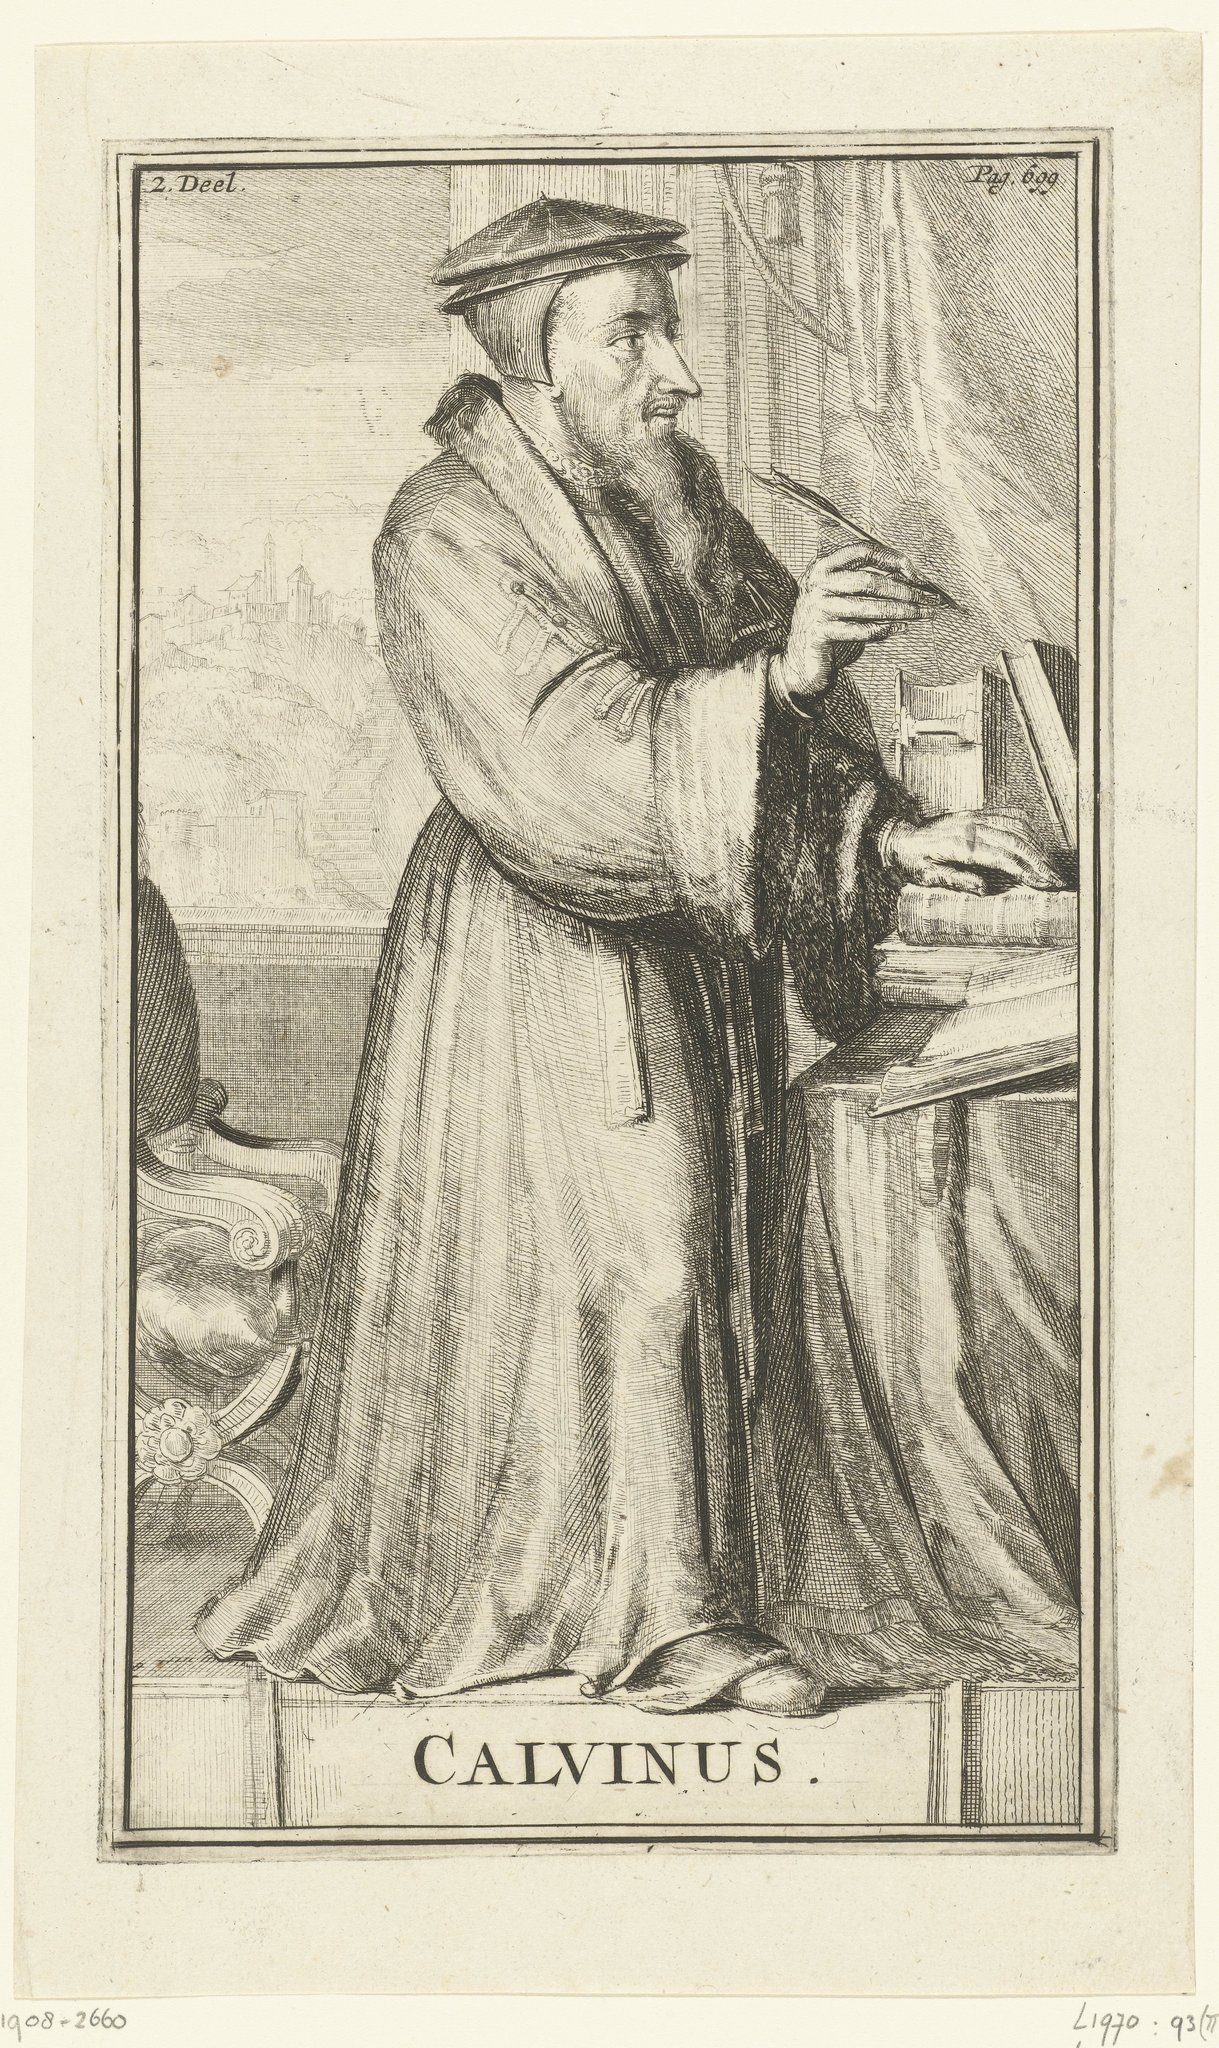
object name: print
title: Calvinus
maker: romeyn de hooghe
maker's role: draughtsman, goldsmith, painter, print maker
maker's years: 1645-1708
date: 1701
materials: paper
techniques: engraving, etching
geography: netherlands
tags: genève, theoloog, hervormer, johannes calvijn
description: Portret van Johannes Calvijn uit een serie portretten in Historie der Kerken en ketteren van den beginne des Nieuwen Testaments tot aan het jaar onses Heeren 1688 van Godfried Arnold (1701).